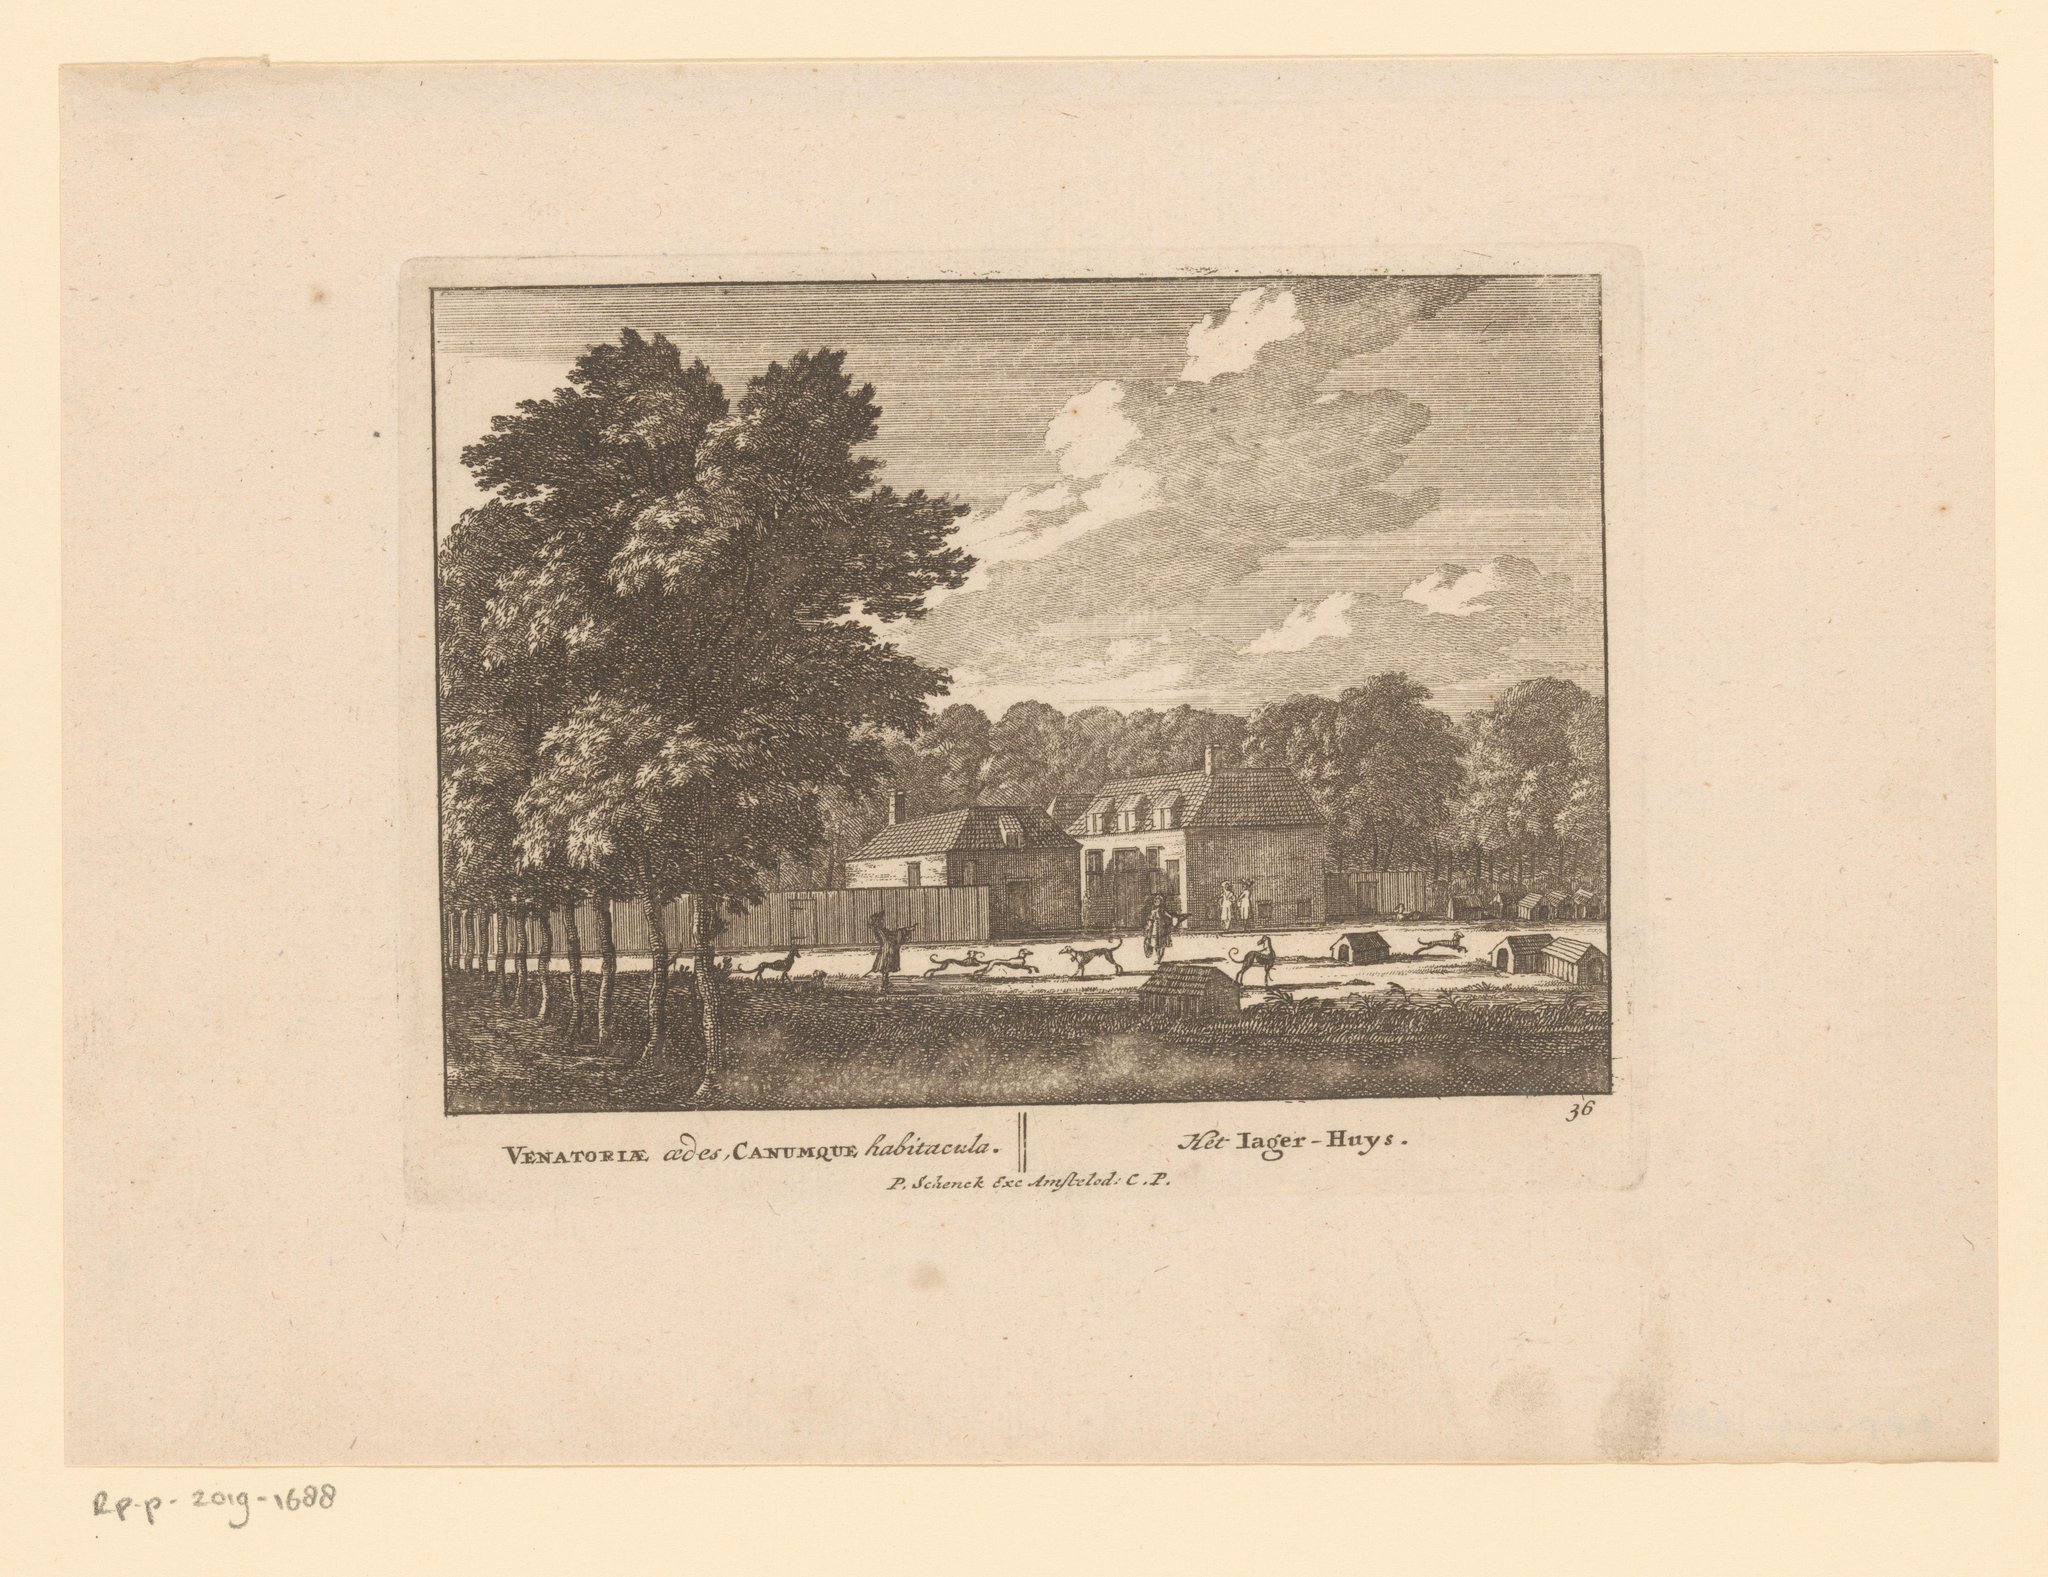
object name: print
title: Venatoriae aedes, Canumque habitacula / Het Jager-Huys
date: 1700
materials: paper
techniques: etching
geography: amsterdam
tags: training of hunting dog, sports, games ~ animals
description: Andere staat ook gebruikt in: Call, Jan van. Admirandorum Quadruplex Spectaculum. Amsterdam: Pieter Schenk (I), [1700].* * De titelprent, opdracht en het portret van Frederik van Saksen zijn gegraveerd door Pieter Schenk (I). De overige prenten uit deze serie zijn, zoals aangegeven op de titelprent, van de hand van Jan van Call (I).